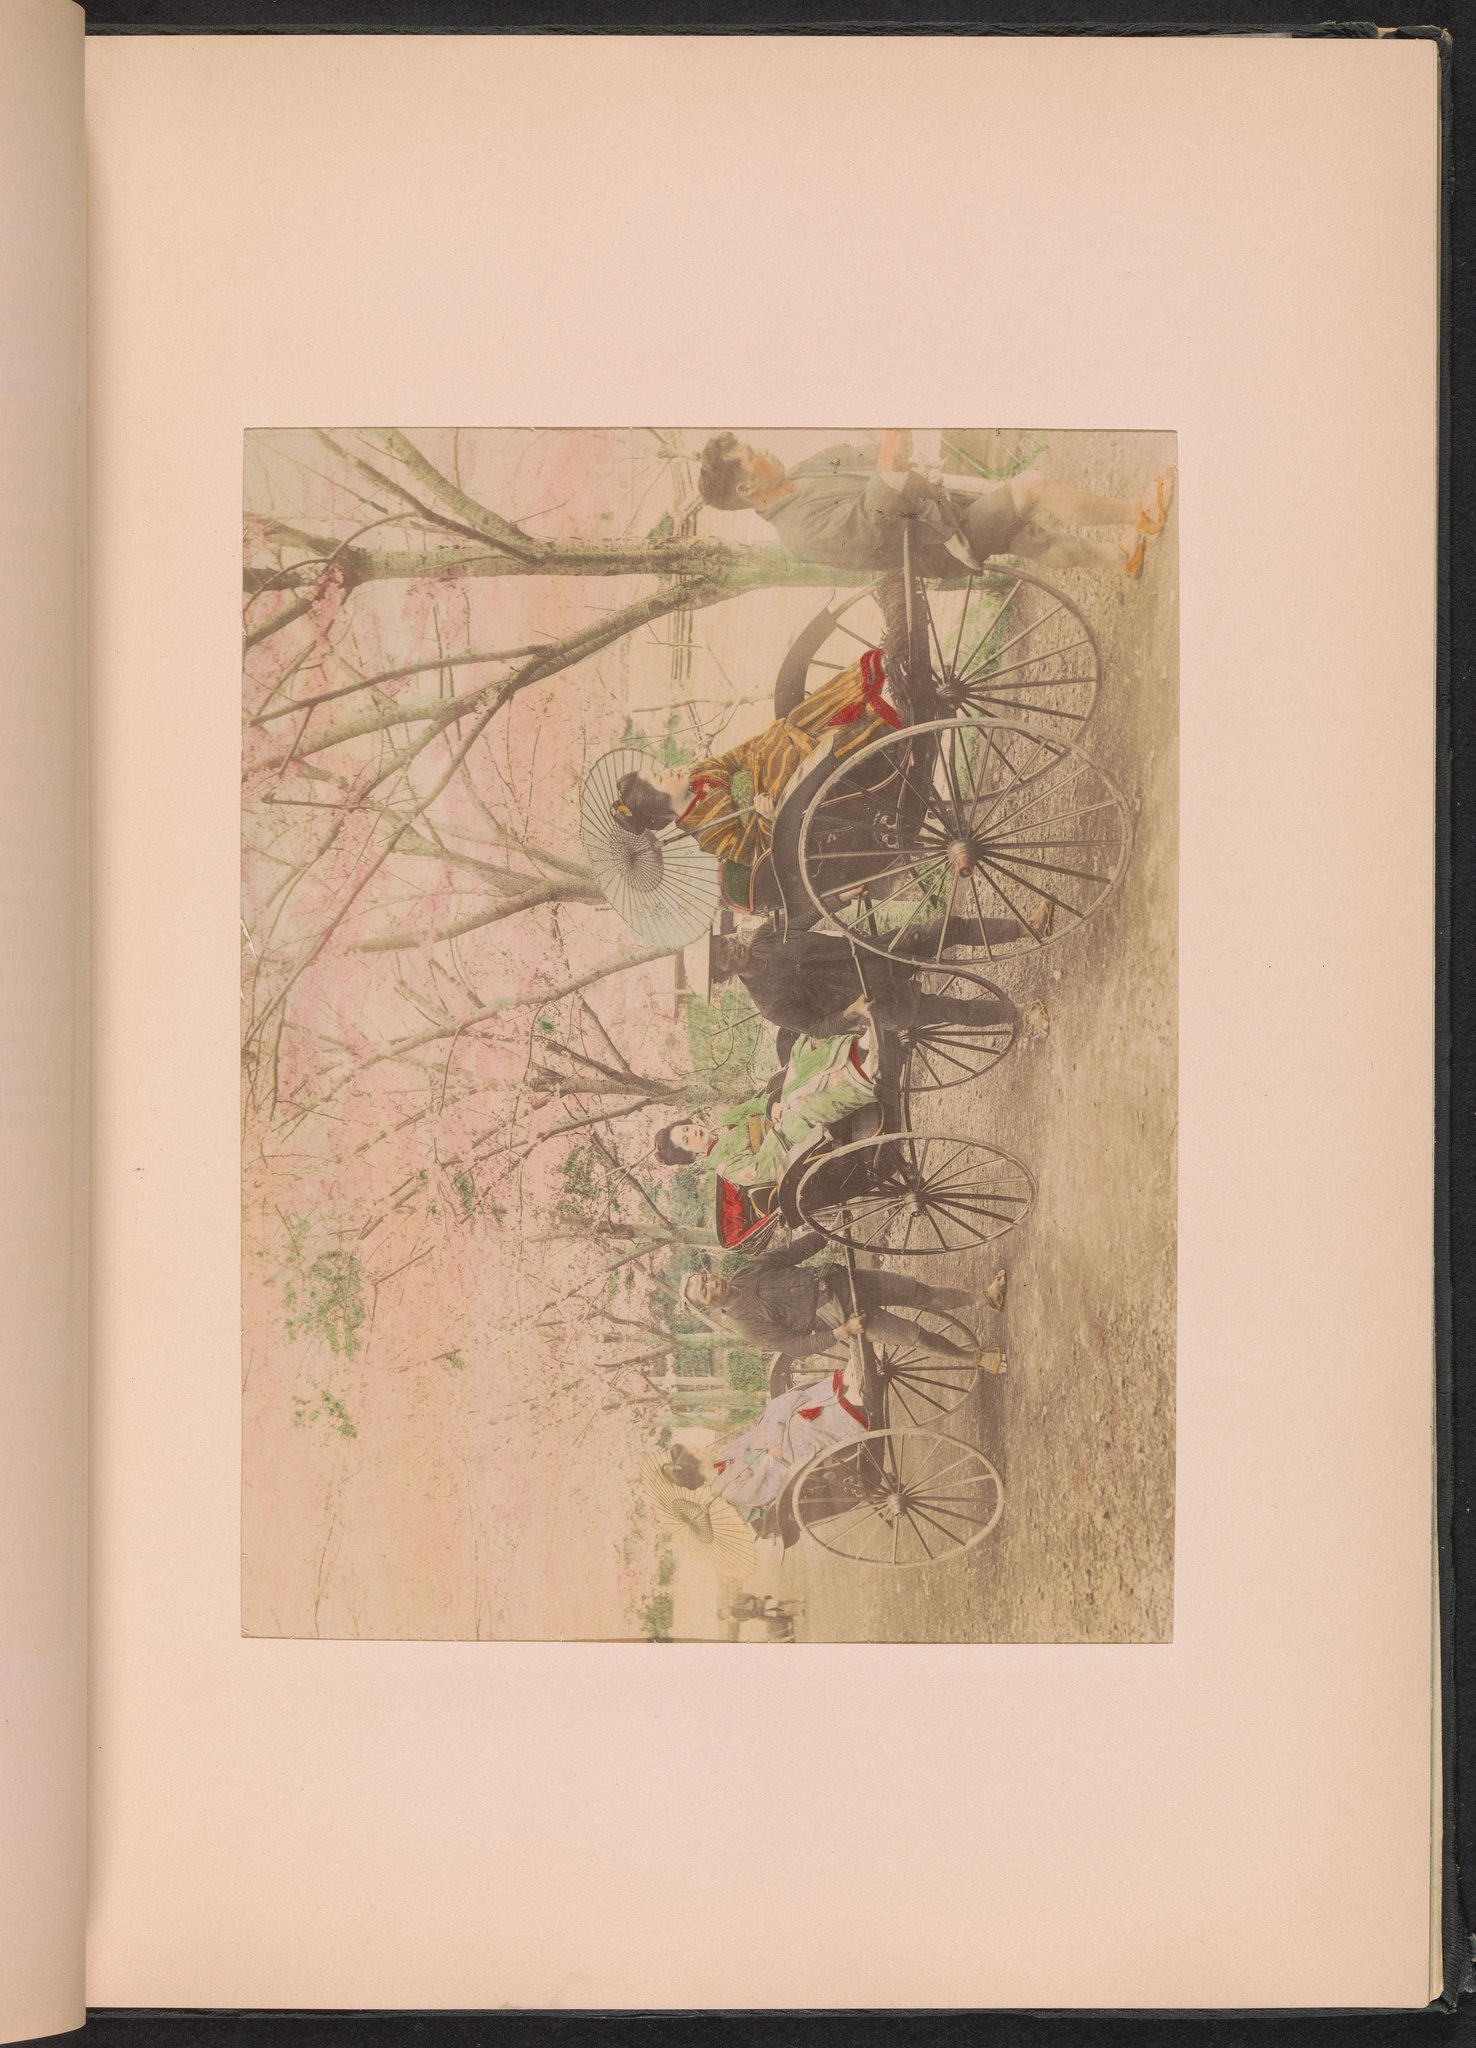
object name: photograph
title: Drie riksja's met vrouwen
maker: Anonymous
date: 1887-1897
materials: photographic support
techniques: albumen print, hand coloring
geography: japan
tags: rickshaw, parasol, sunshade